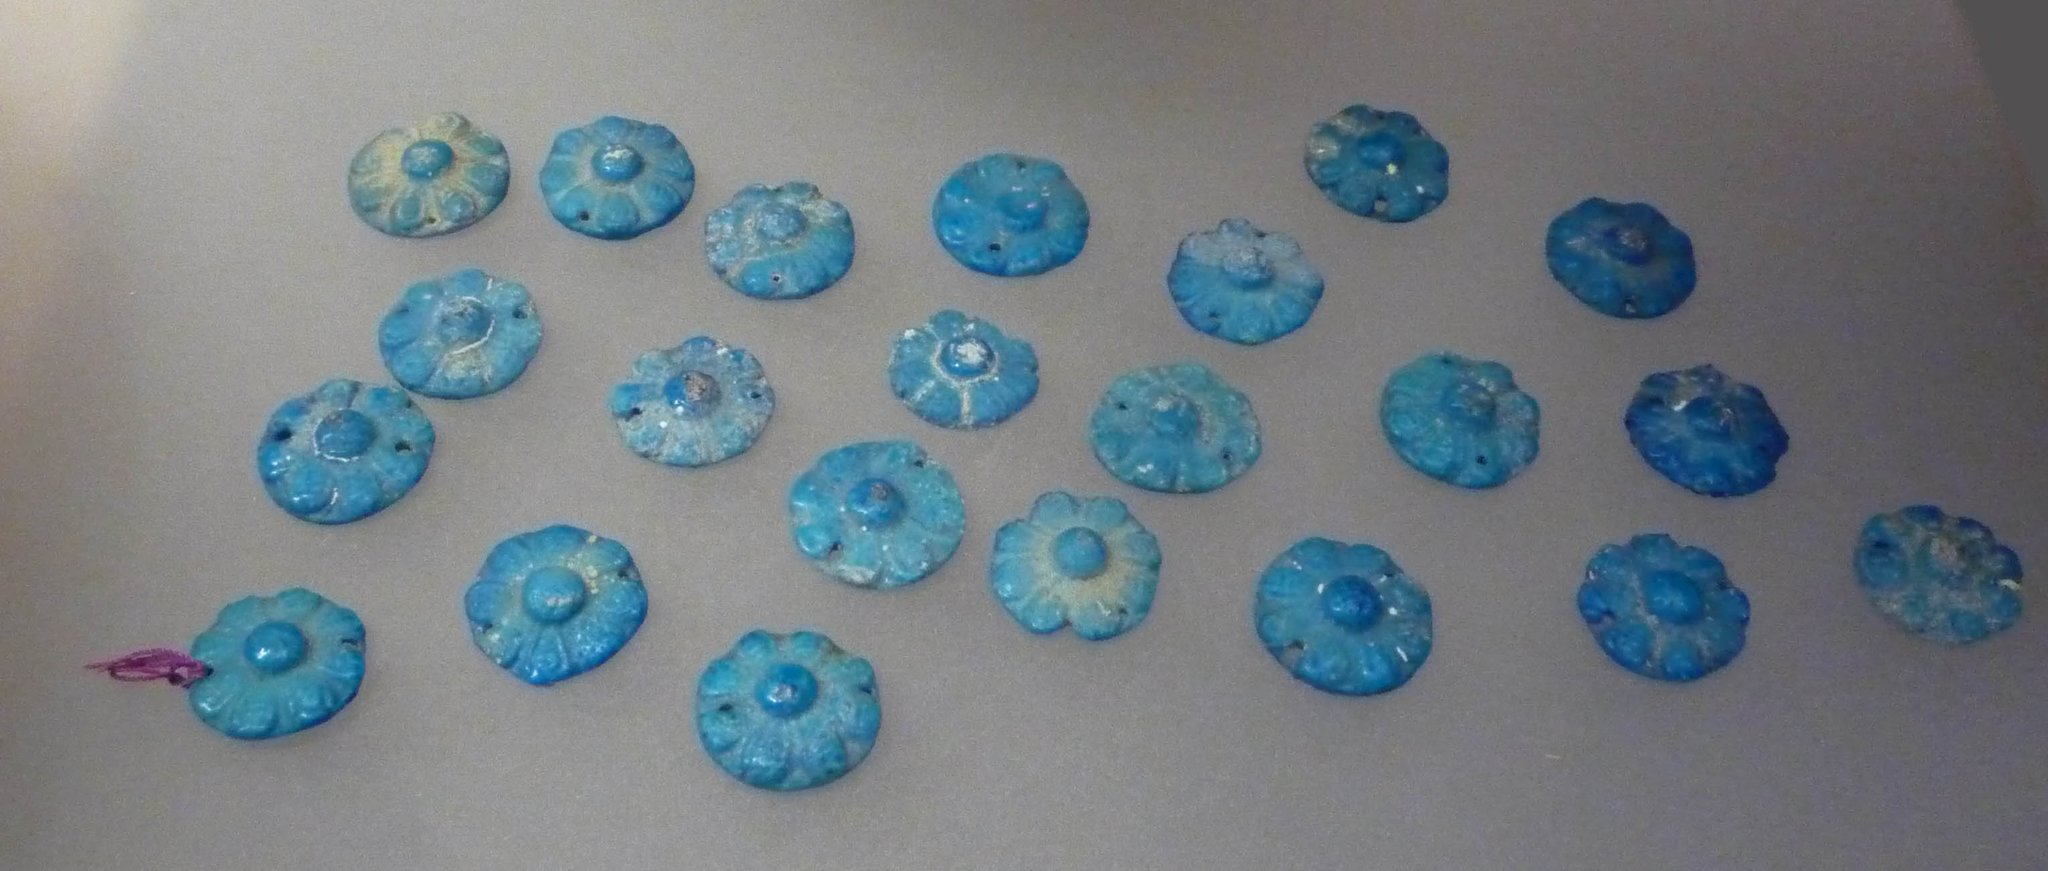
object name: rosette 32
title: Thirty-two Rosettes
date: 1479-1458 BCE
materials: faience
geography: egypt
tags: flowers